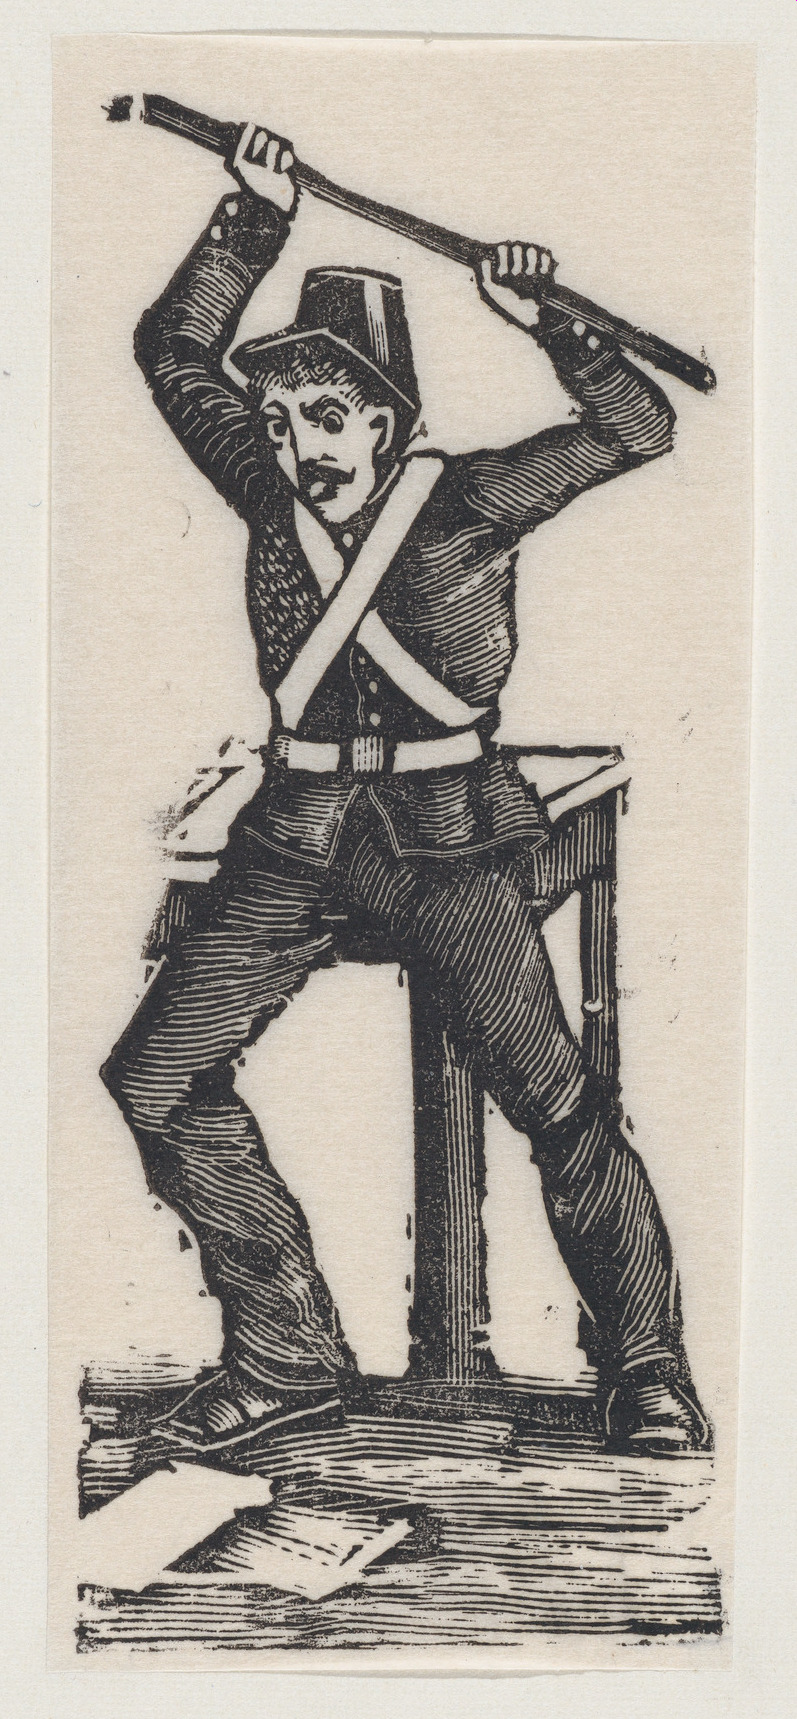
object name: print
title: Federal soldier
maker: josé guadalupe posada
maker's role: artist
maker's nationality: mexican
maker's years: 1852-1913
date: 1880-1910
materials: metal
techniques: engraving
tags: soldiers,men